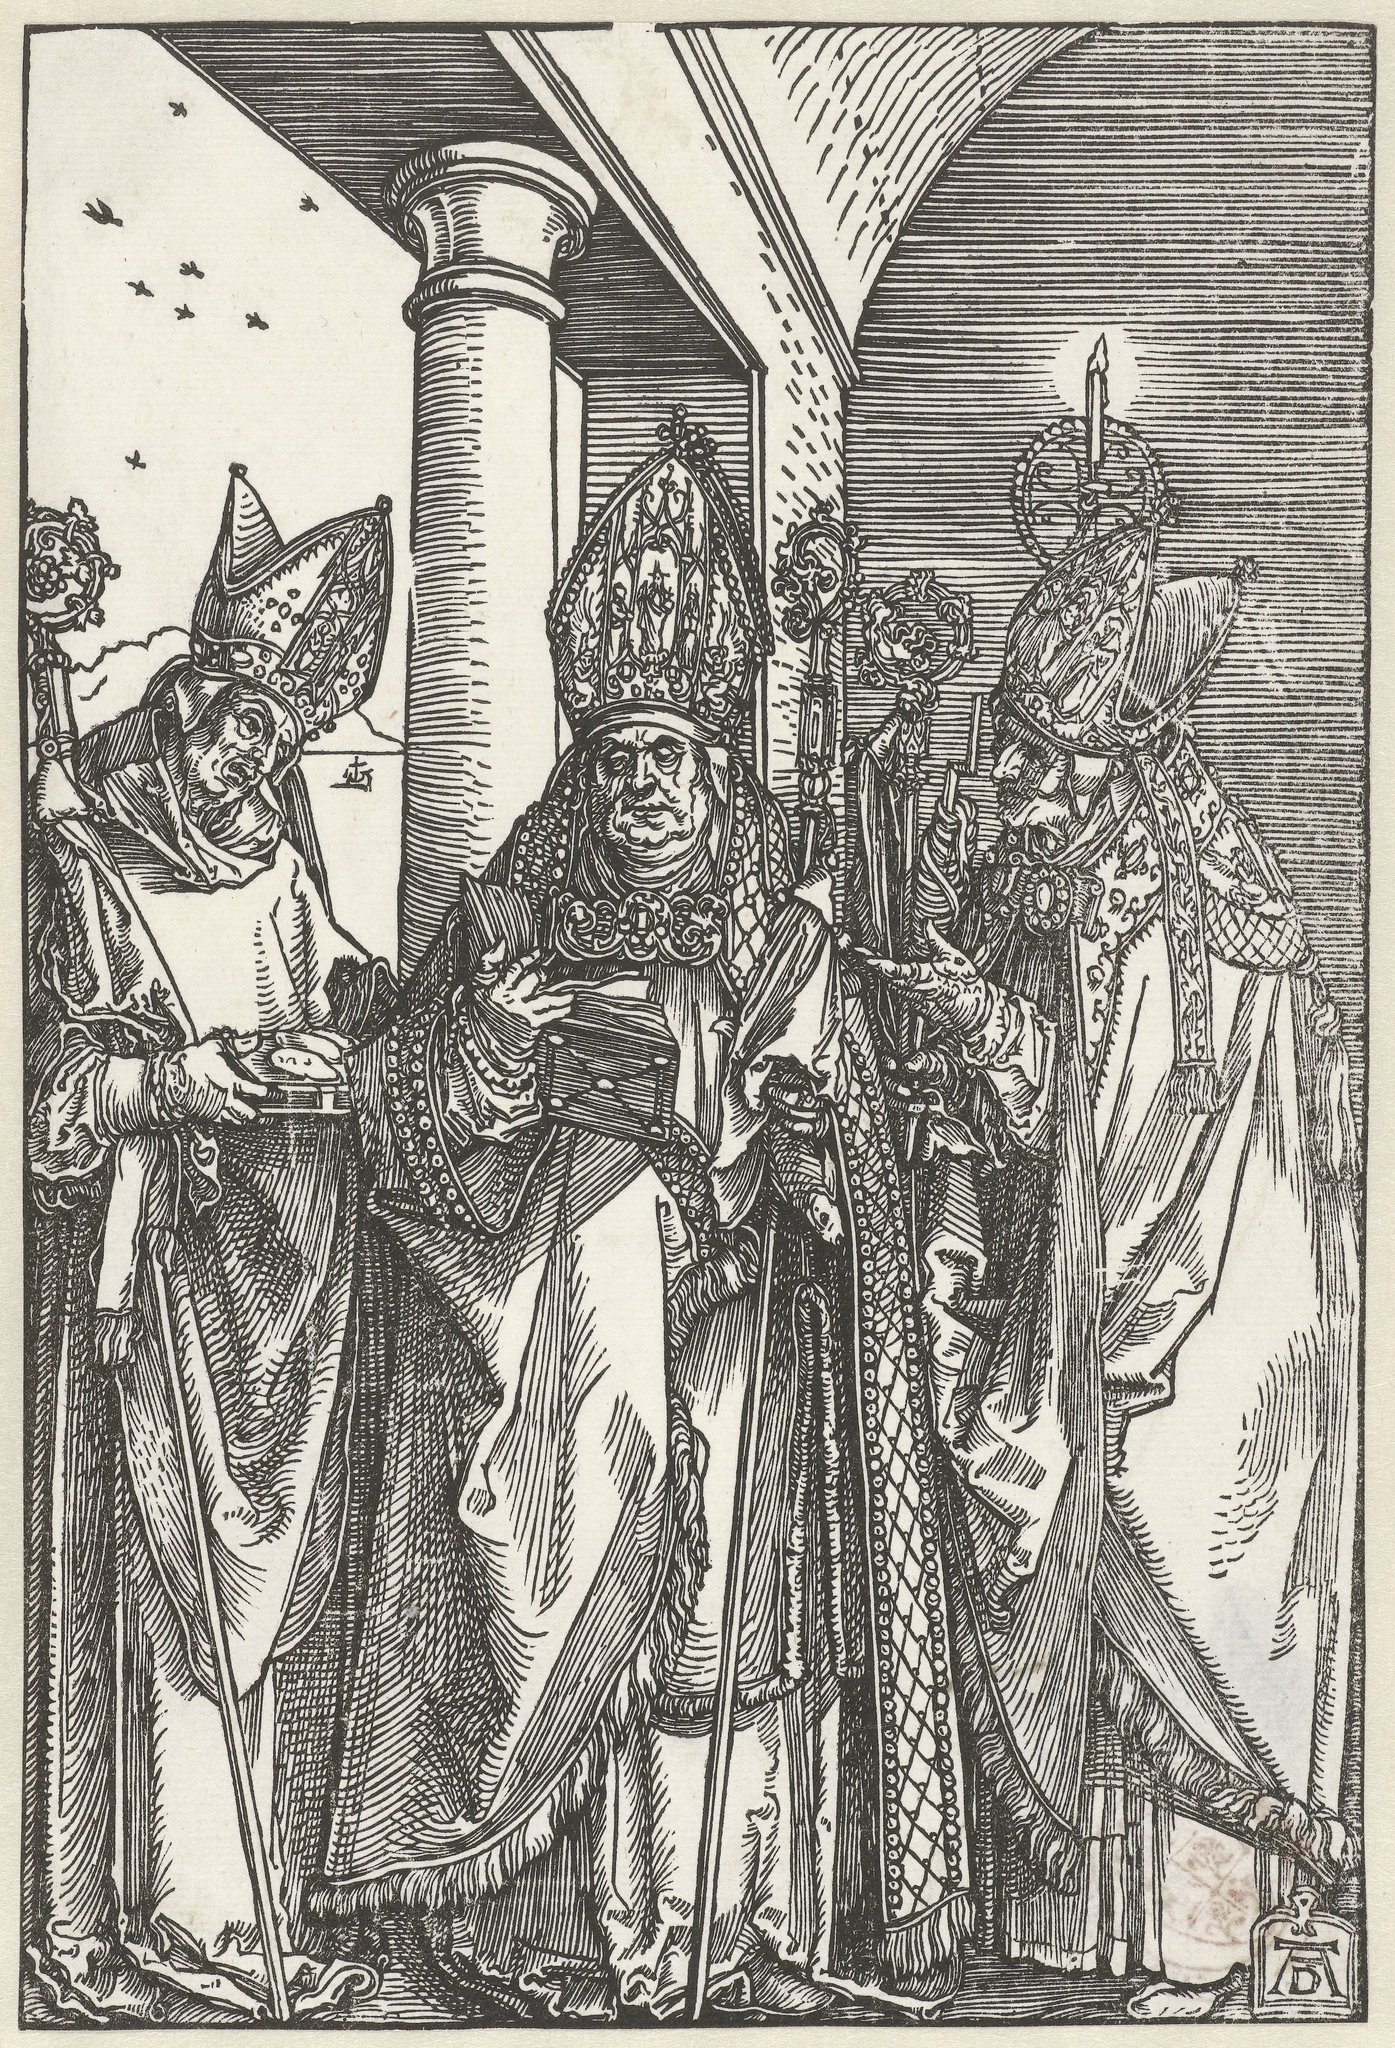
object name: print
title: De Heilige Nicolaas, Ulrich van Augsburg en Erasmus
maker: albrecht dürer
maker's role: draughtsman, painter, print maker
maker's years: 1471-1528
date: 1503-1507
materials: paper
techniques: woodcut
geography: nuremberg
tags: ulrich, bishop of augsburg; possible attributes: fish, rat, the bishop nicholas of myra (or bari); possible attributes: anchor, boat, three golden balls (on a book), three purses, three children in a tub, three maidens, the martyr erasmus (elmo), bishop of formiae; possible attributes: boat, capstan, carpenter's nails under fingernails, cauldron, windlass with entrails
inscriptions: collector's mark: Lugt 240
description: De Heilige Nicolaas, Ulrich van Augsburg en Erasmus staan naast elkaar in een ruimte bij een pilaar, waarachter een baai te zien is. Ze zijn alledrie gekleed als bisschop.